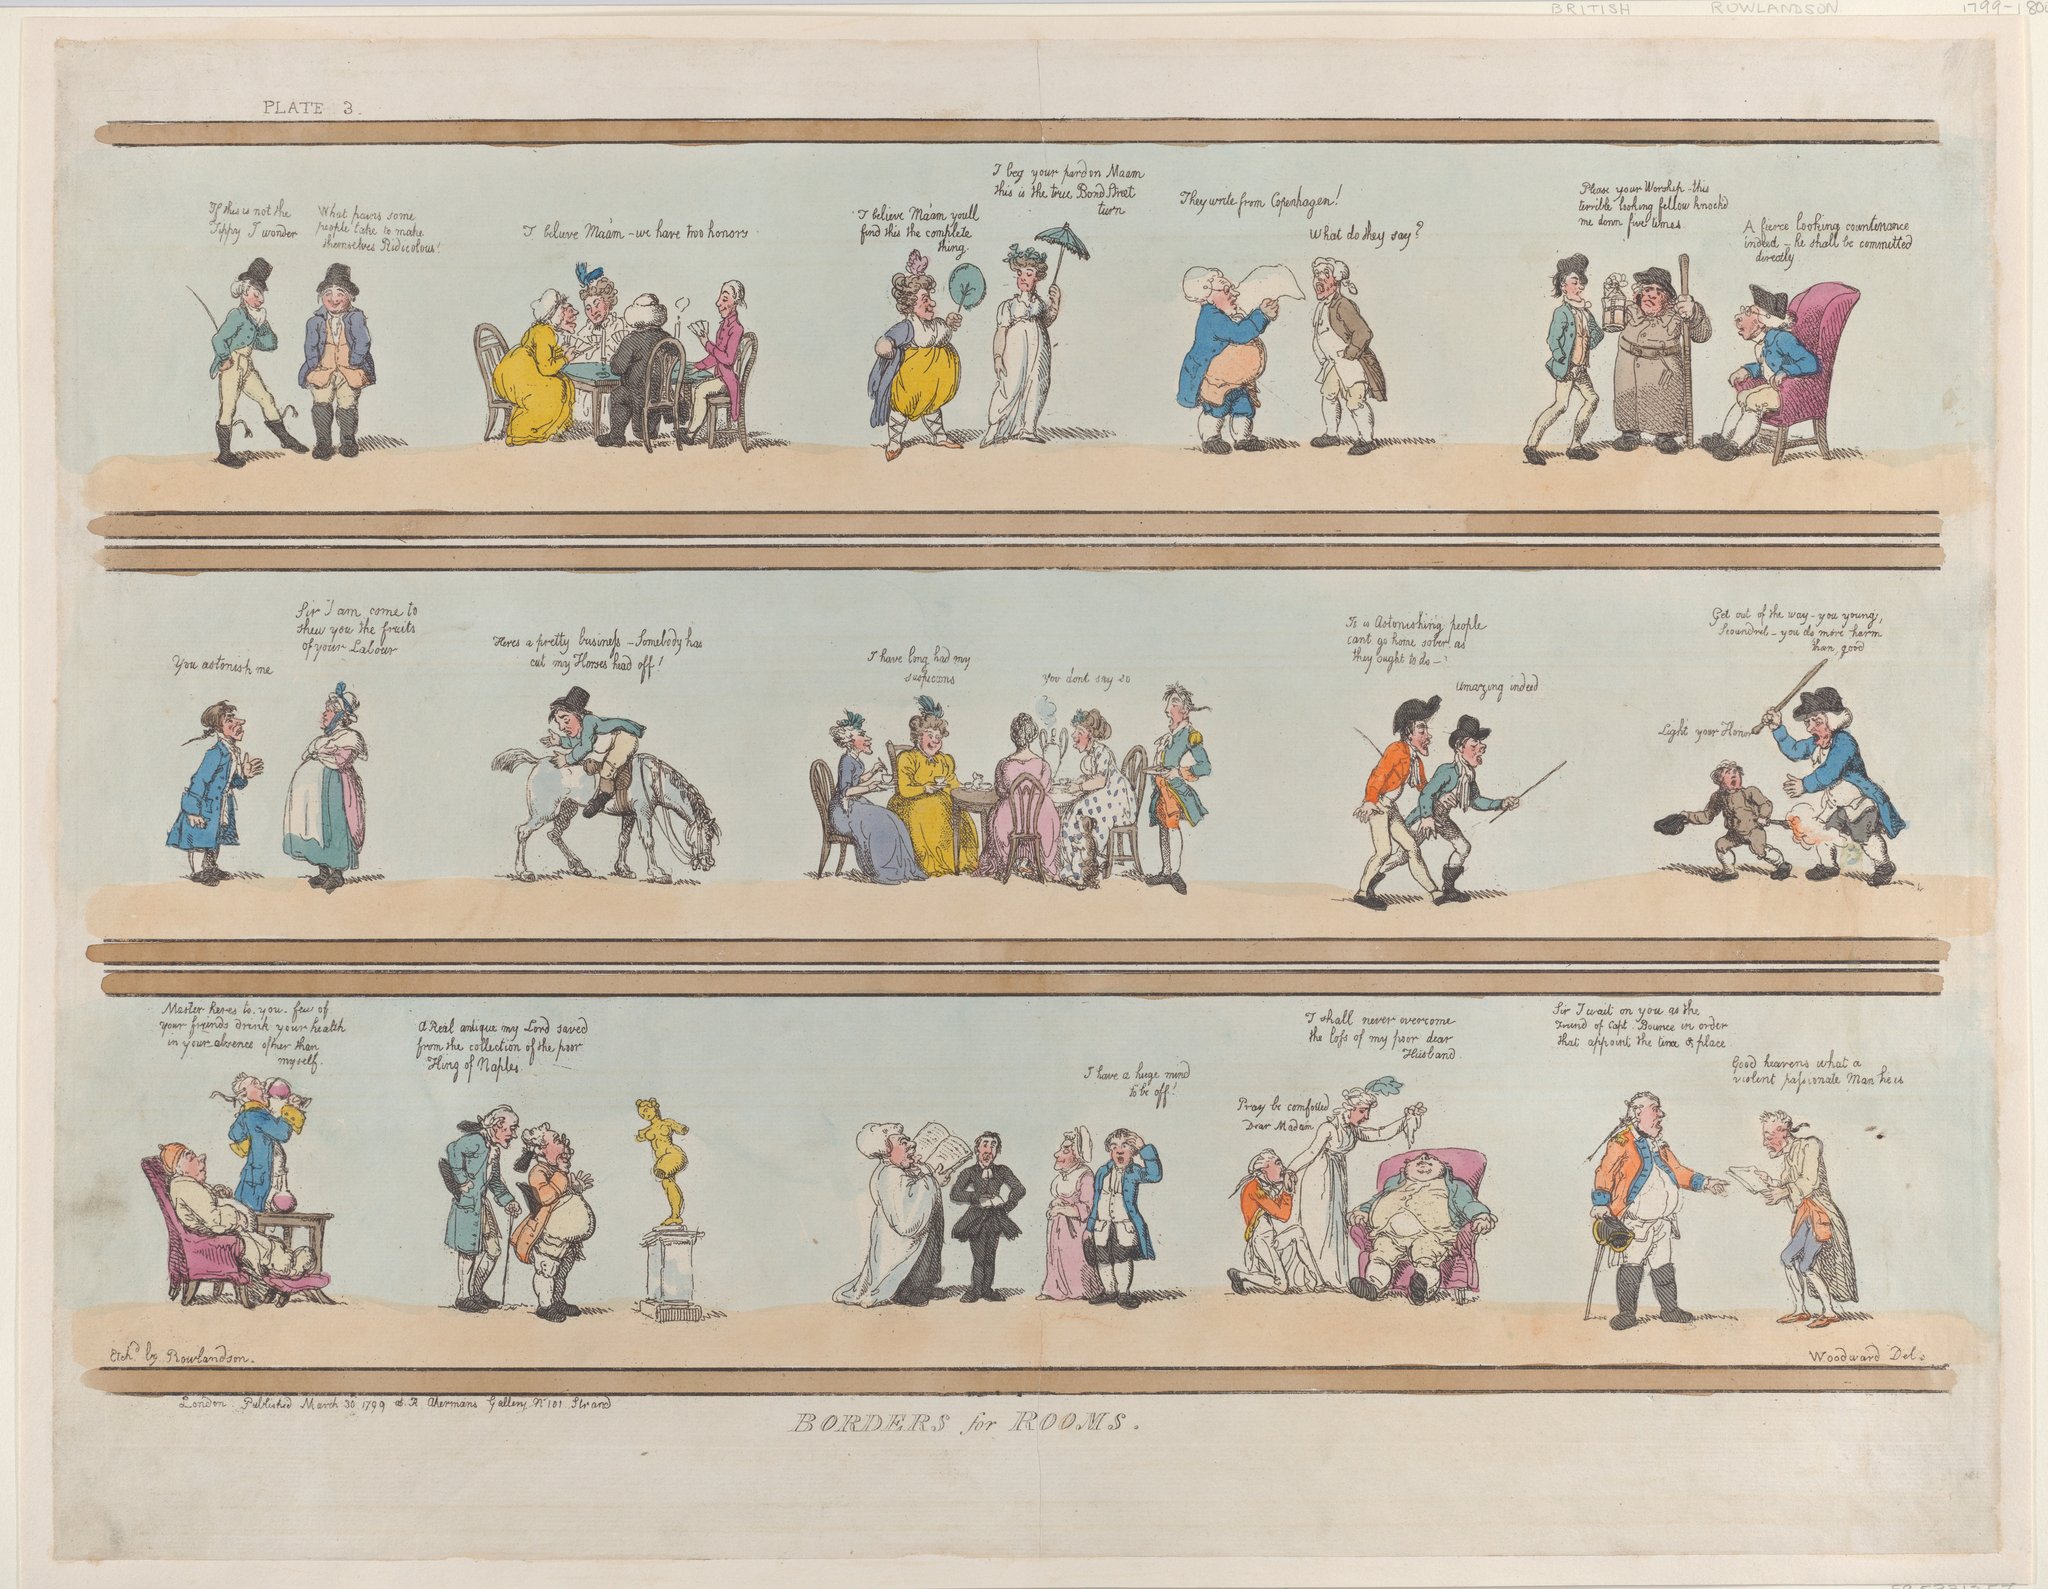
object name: print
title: Borders for Rooms, Plate 3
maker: thomas rowlandson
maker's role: artist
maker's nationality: british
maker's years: 1757-1827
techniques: etching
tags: satire,men,women